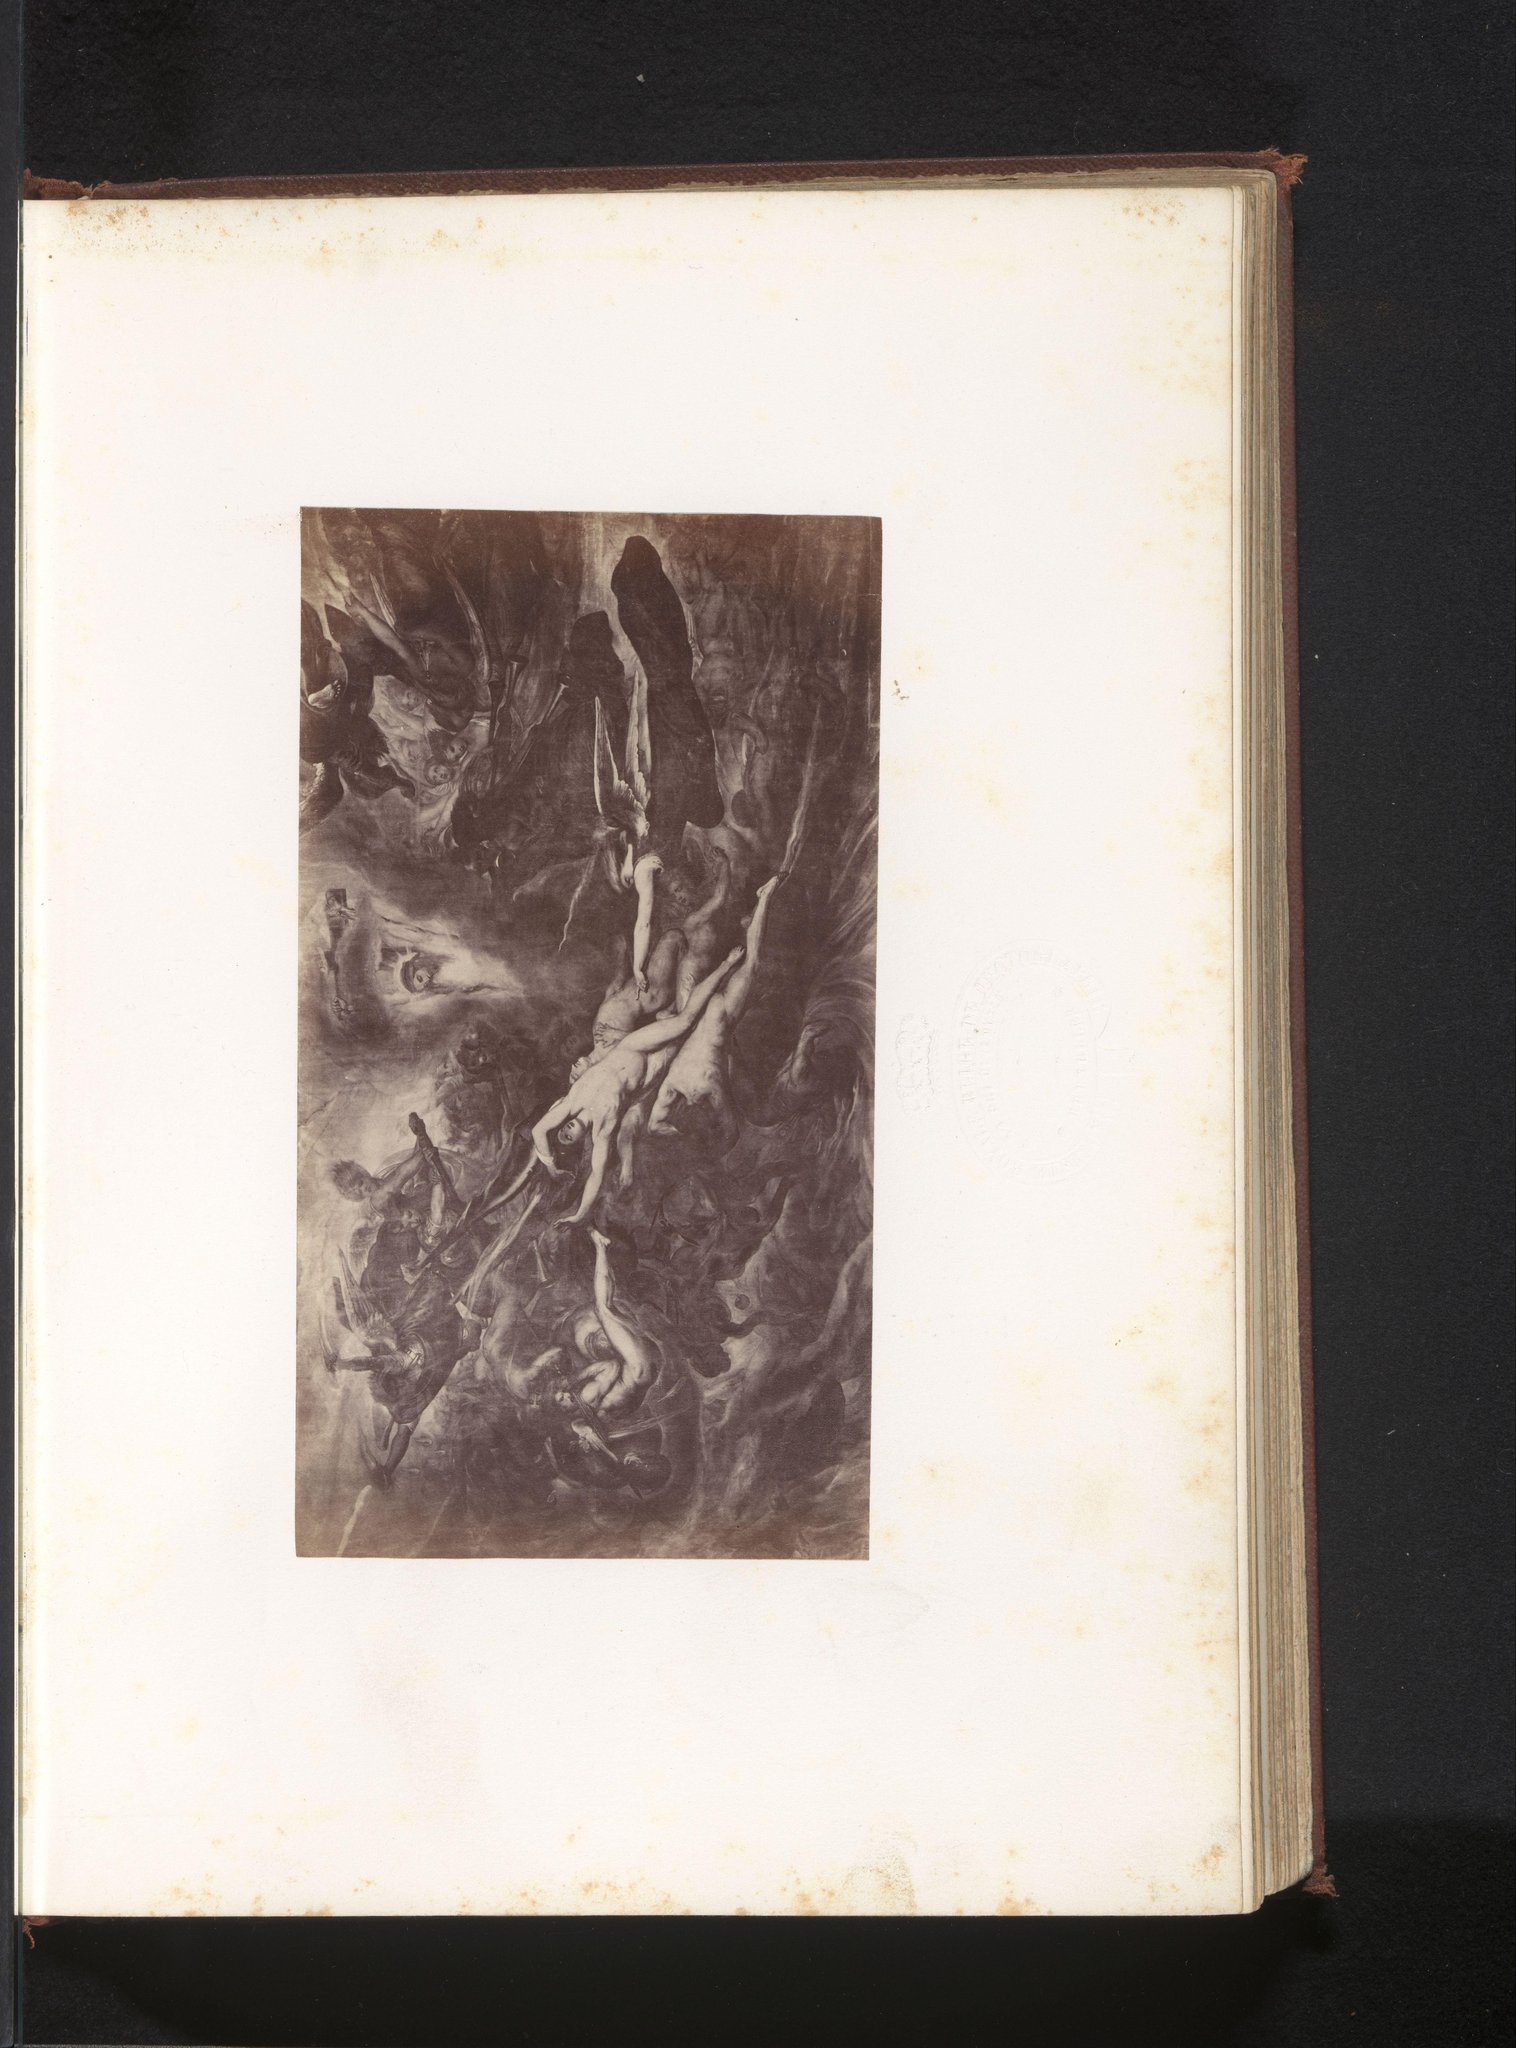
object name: photograph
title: Fotoreproductie van De triomf van Christus door Antoine Wiertz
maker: edmond fierlants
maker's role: fotograaf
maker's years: 1819-1869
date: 1863-1868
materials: photographic support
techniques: albumen print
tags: christ triumphing over devil(s)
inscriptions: check stamp: ‘SOCIÉTÉ ROYALE BELGE DE PHOTOGRAPHIE/ 69, RUE KEYENVELD/ BRUXELLES’